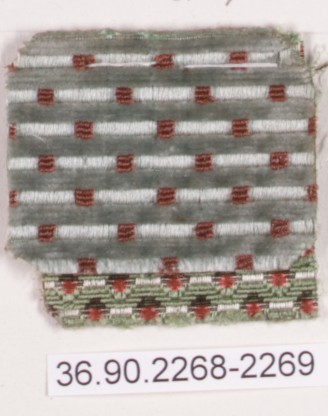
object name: piece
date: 1801-1900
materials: silk